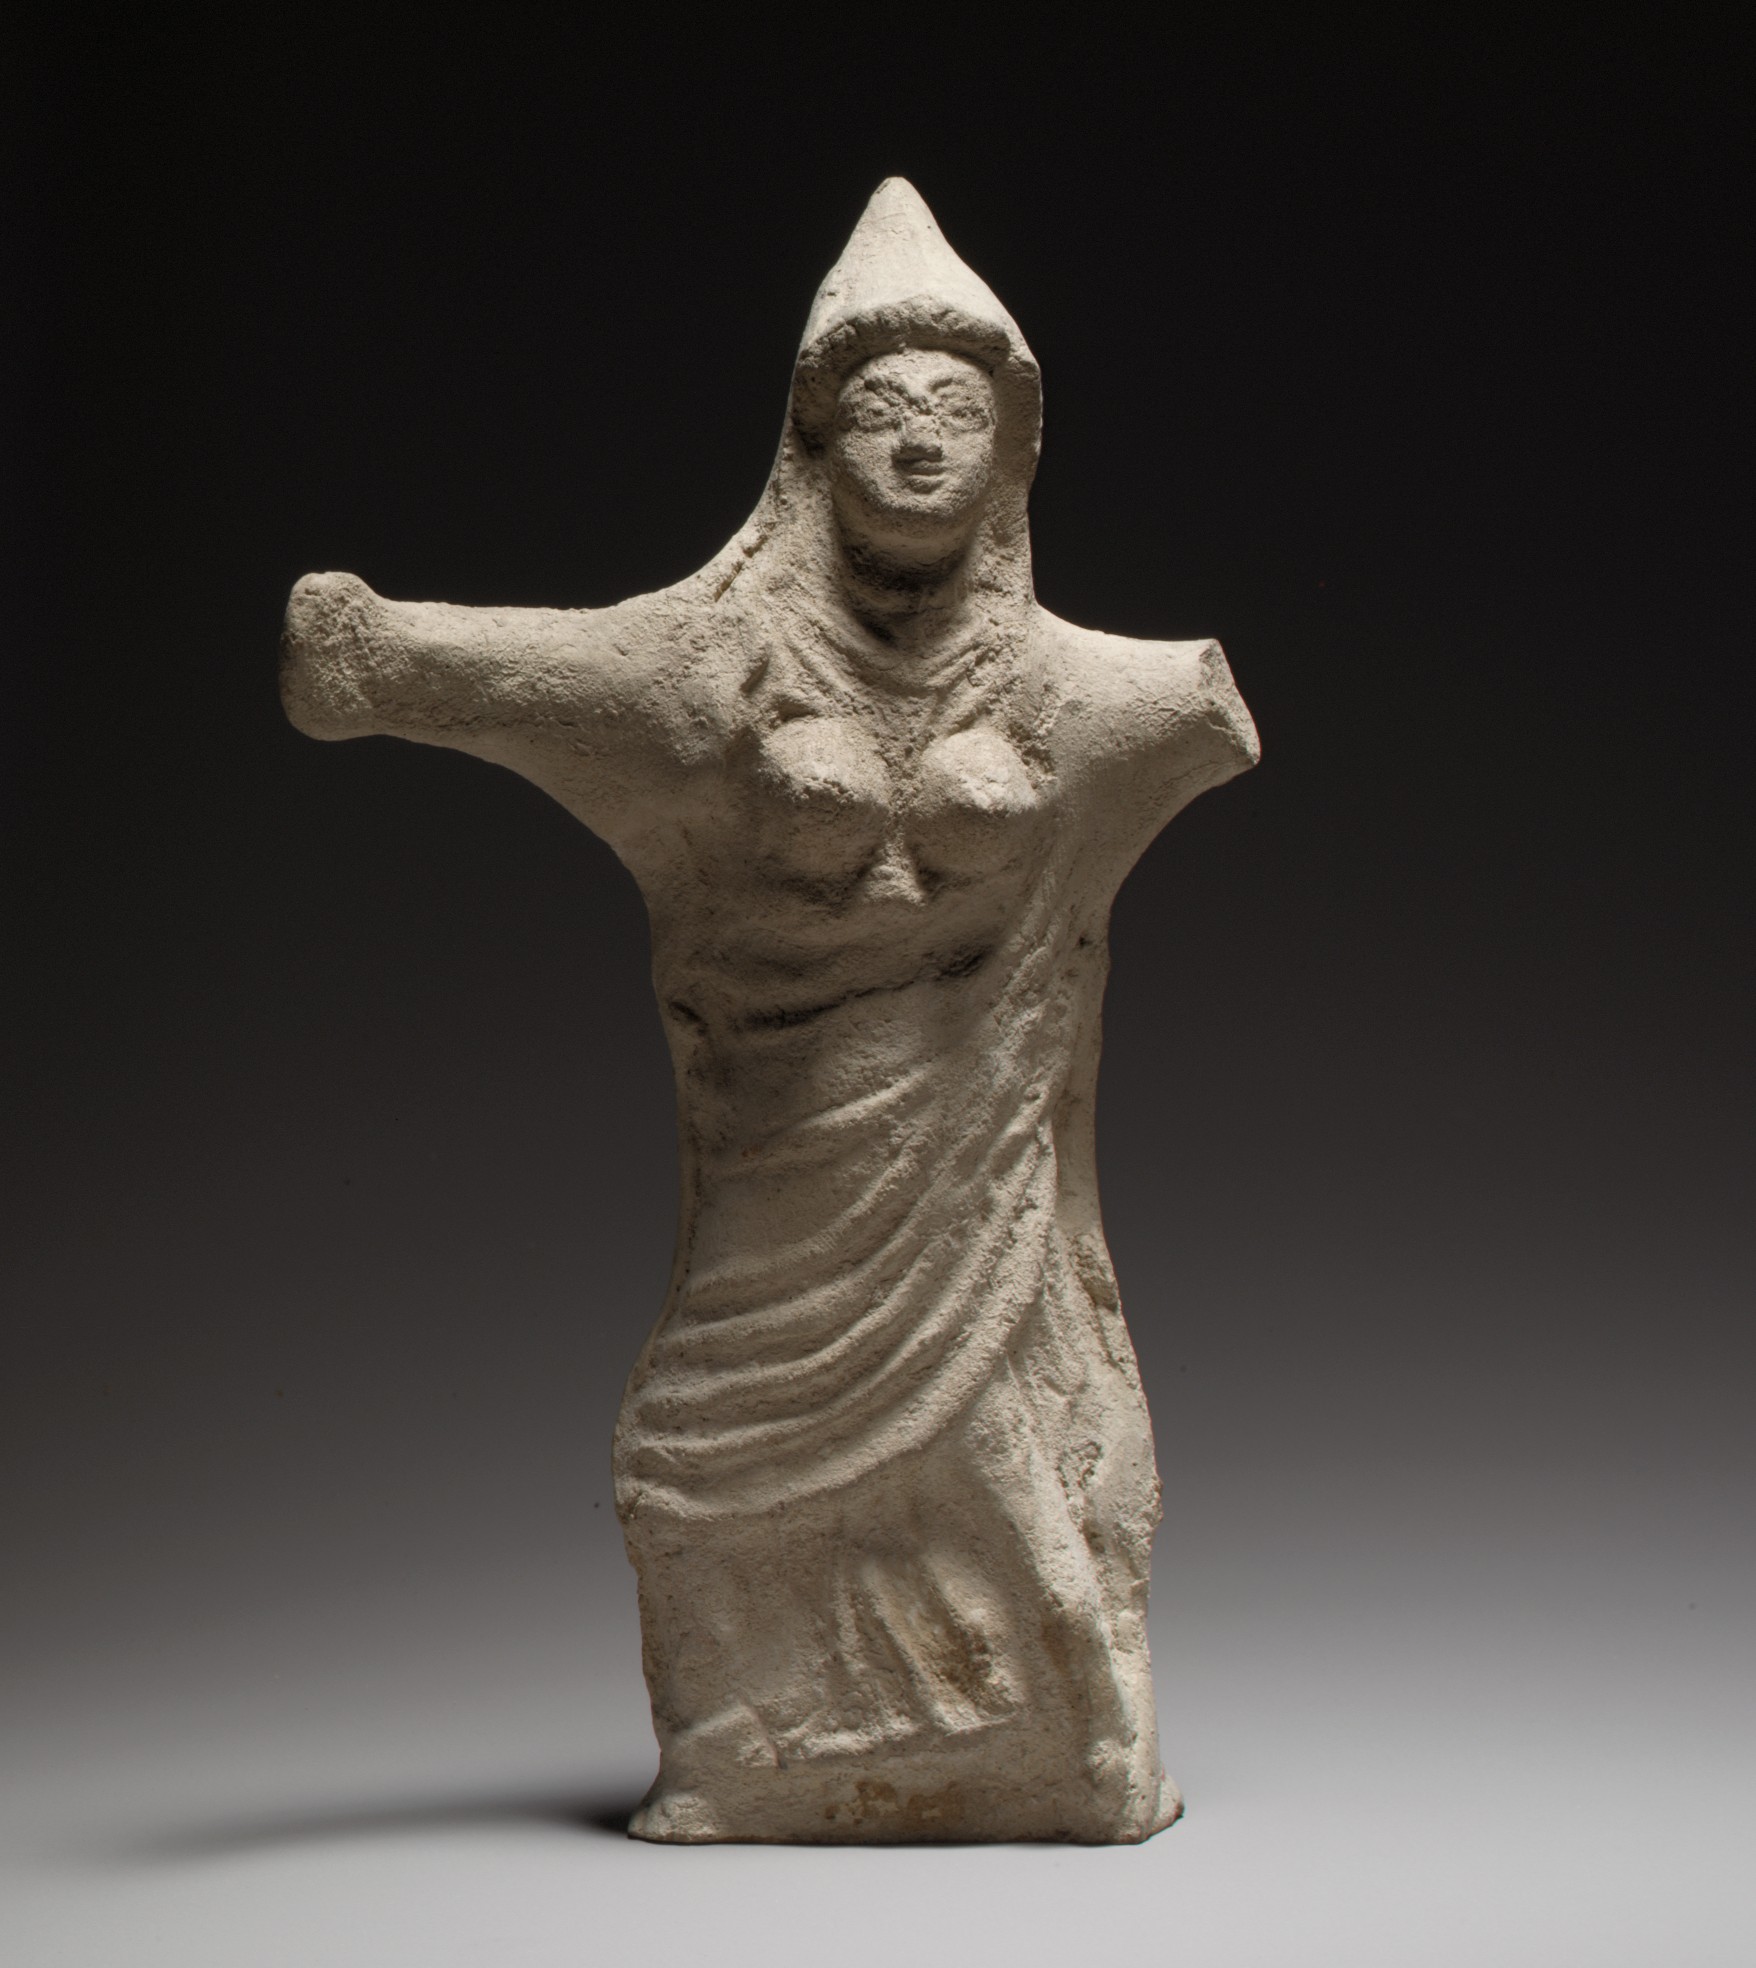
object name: statuette of a female from a ring dance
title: Female ring dancer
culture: cypriot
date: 500-301 BCE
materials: terracotta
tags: women,dancers